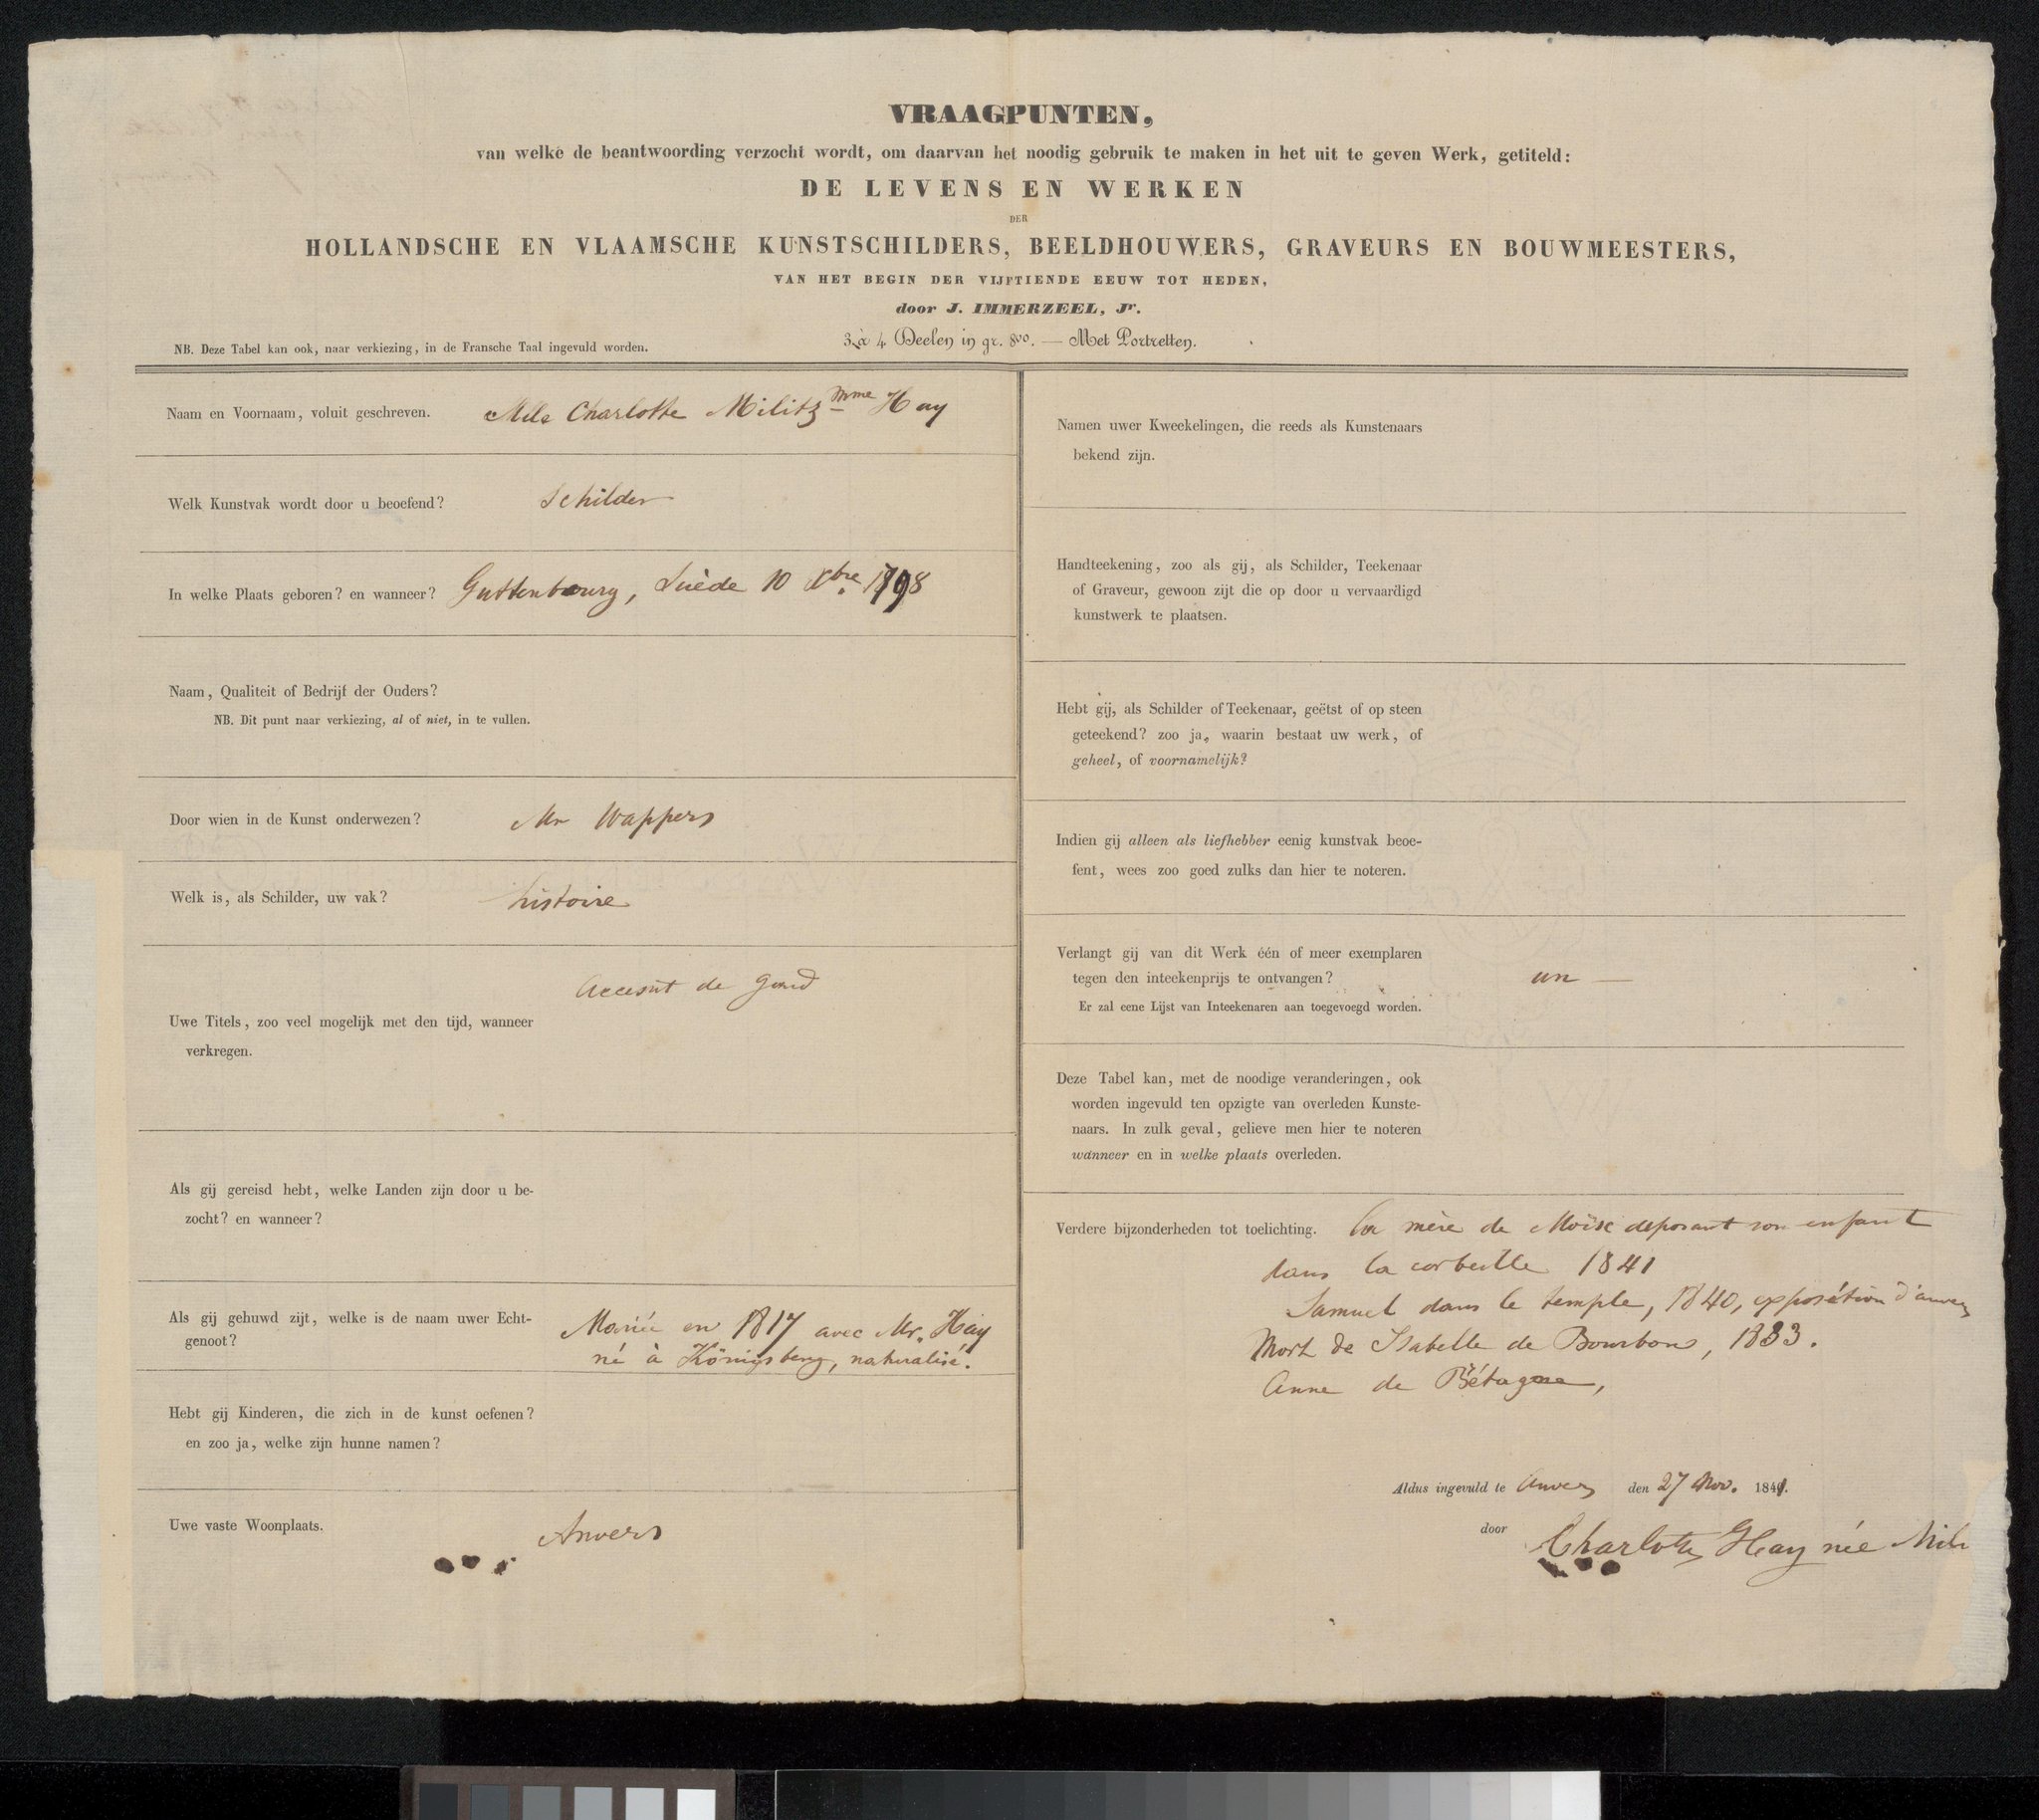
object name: questionnaire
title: Enquêteformulier ingevuld door Charlotte Hay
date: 1841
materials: ink, paper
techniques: pen, printing, writing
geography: antwerp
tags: painter, charlotte hay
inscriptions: inscription: ‘Vraagpunten,/ van welke de beantwoording verzocht wordt, om daarvan het noodig gebruik te maken in het uit te geven Werk, getiteld: De levens en werken/ der Hollandsche en Vlaamsche kunstschilders, beeldhouwers,/ graveurs en bouwmeesters, van het begin der vijftiende eeuw tot heden/ door J. Immerzeel, Jr.’, watermark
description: Opgenomen in: Immerzeel, J. Jr., De levens en werken der Hollandsche en Vlaamsche kunstschilders, beeldhouwers, graveurs en bouwmeesters, van het begin der vijftiende eeuw tot heden, Amsterdam: J.C. van Kesteren, 1842-1843.